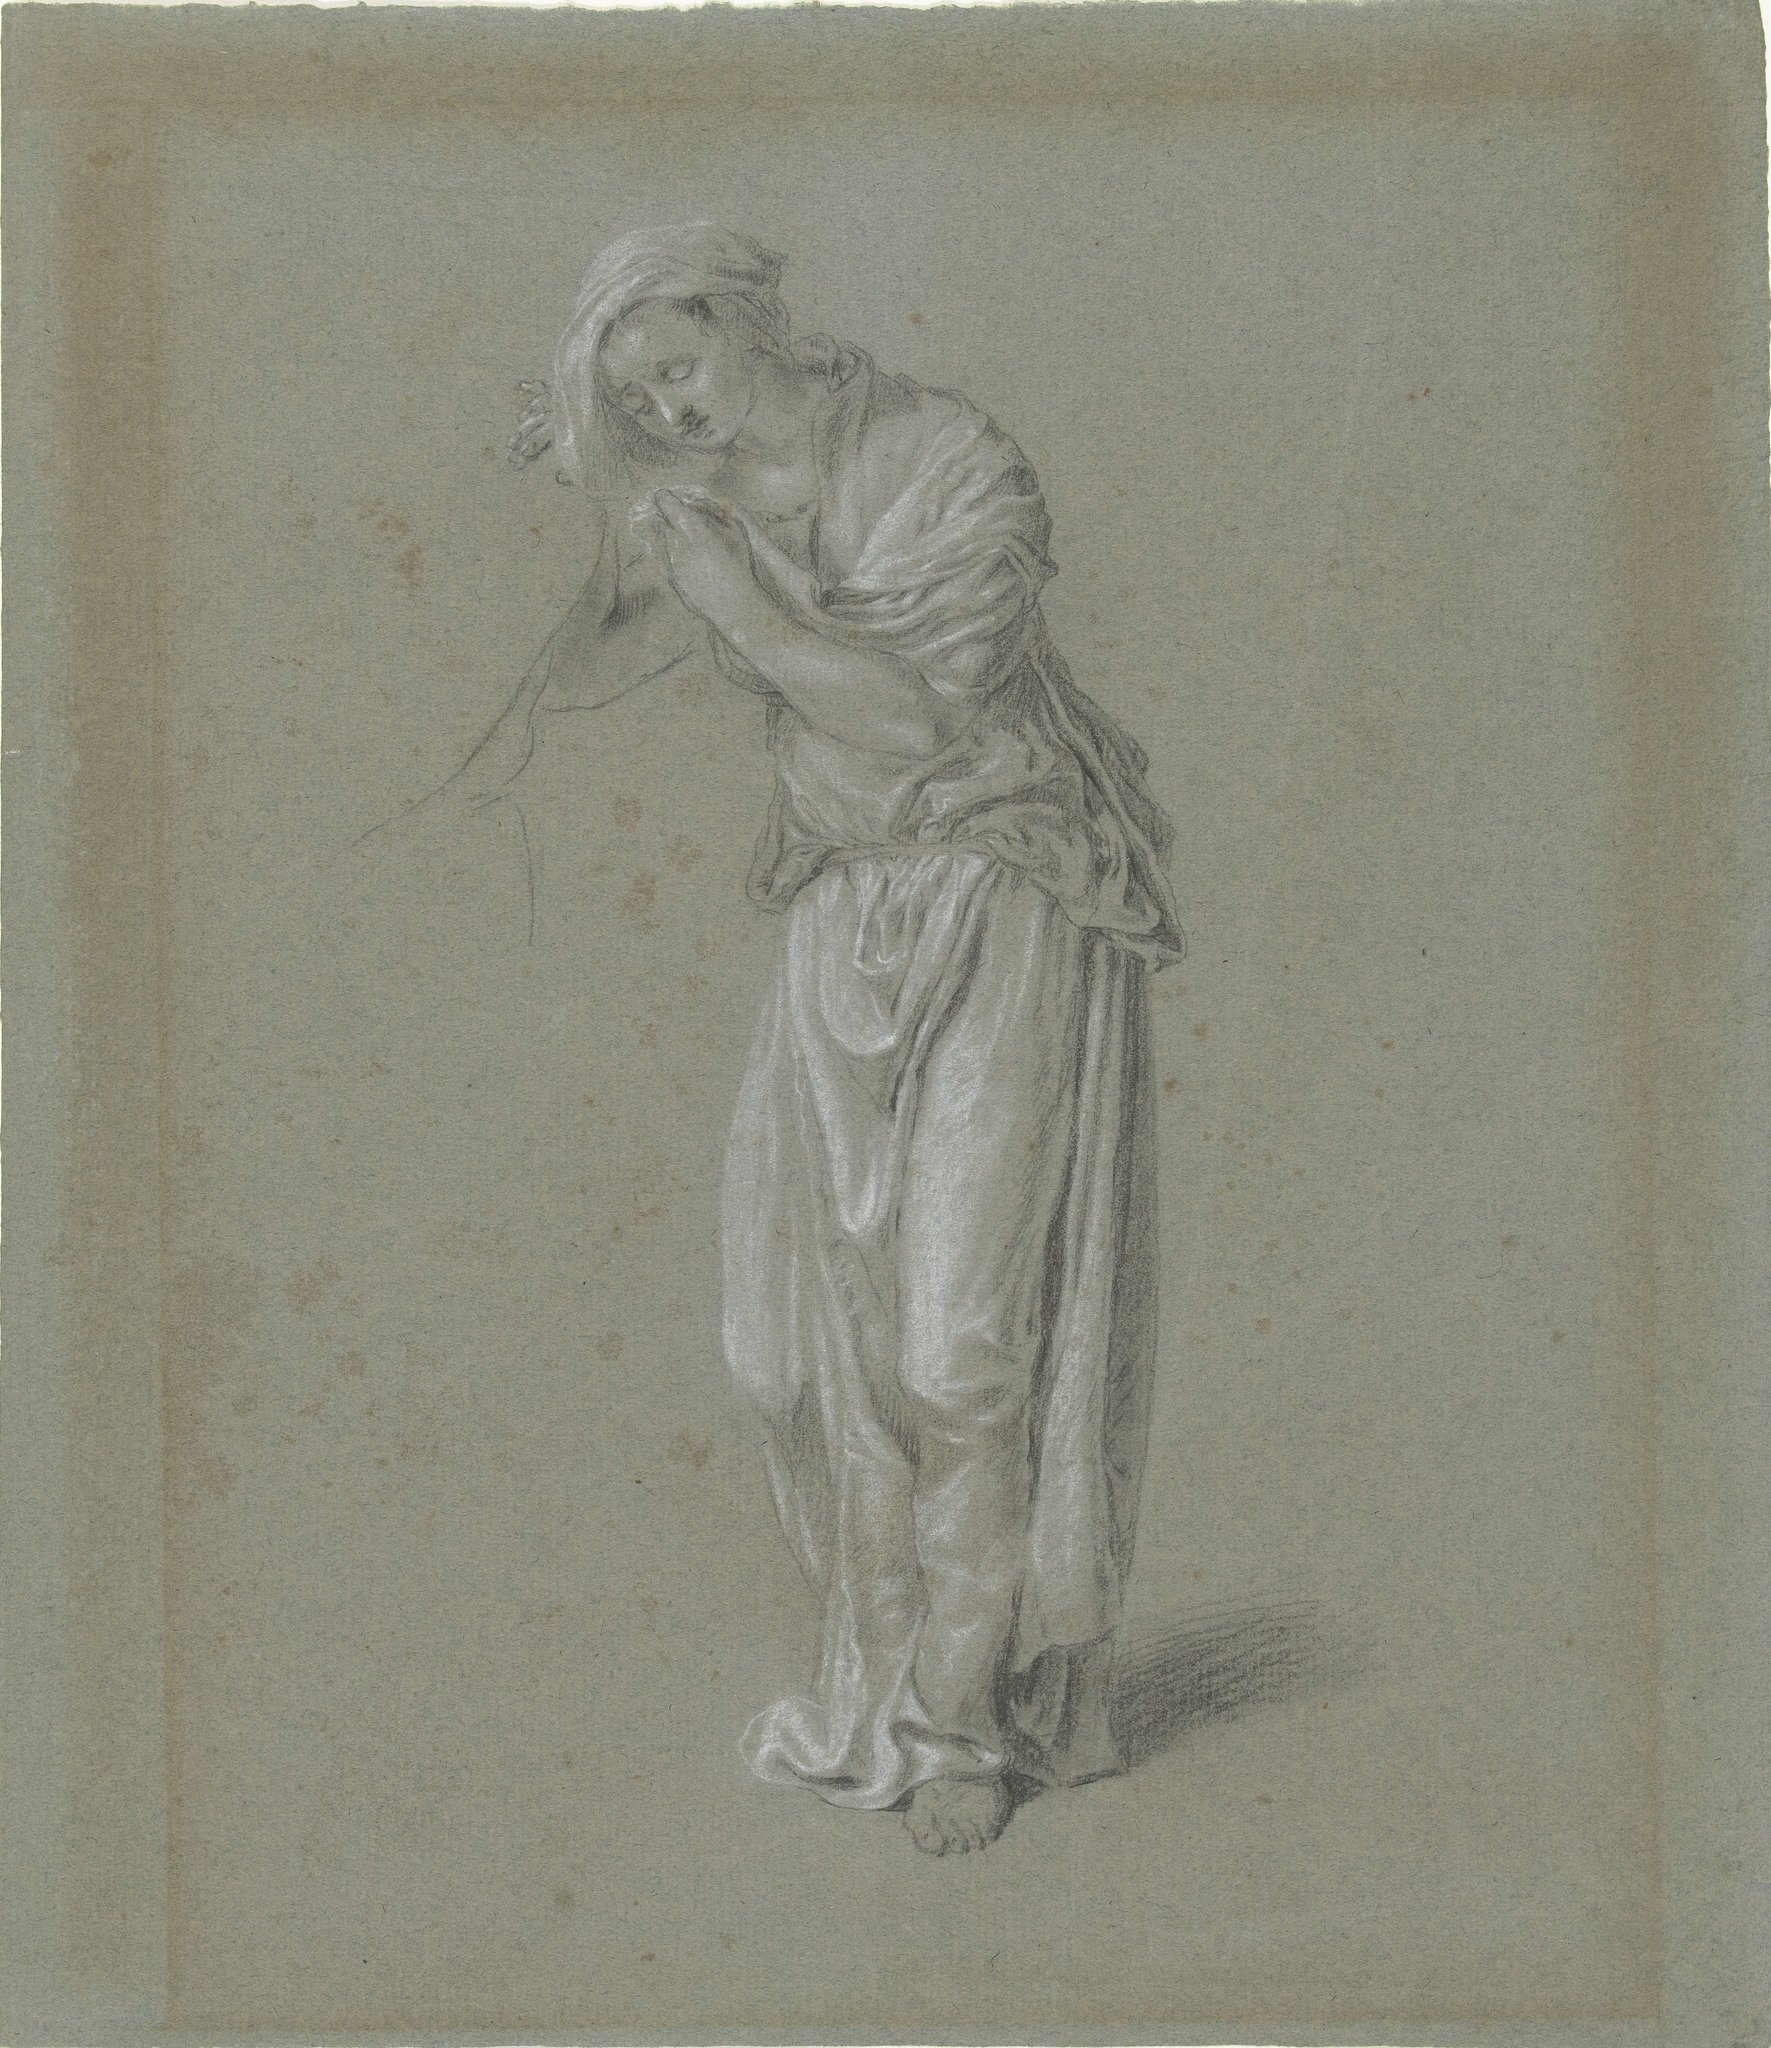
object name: drawing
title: Figuurstudie van een vrouw in klassiek gewaad, leunend op een voorwerp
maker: hendrik hoogers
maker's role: draughtsman, mayor, print maker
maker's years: 1747-1814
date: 1778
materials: chalk, paper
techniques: stumping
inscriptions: date: ‘78’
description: Figuurstudie van een vrouw in klassiek gewaad, staand en leunend op een voorwerp links, met gebogen hoofd treurend.